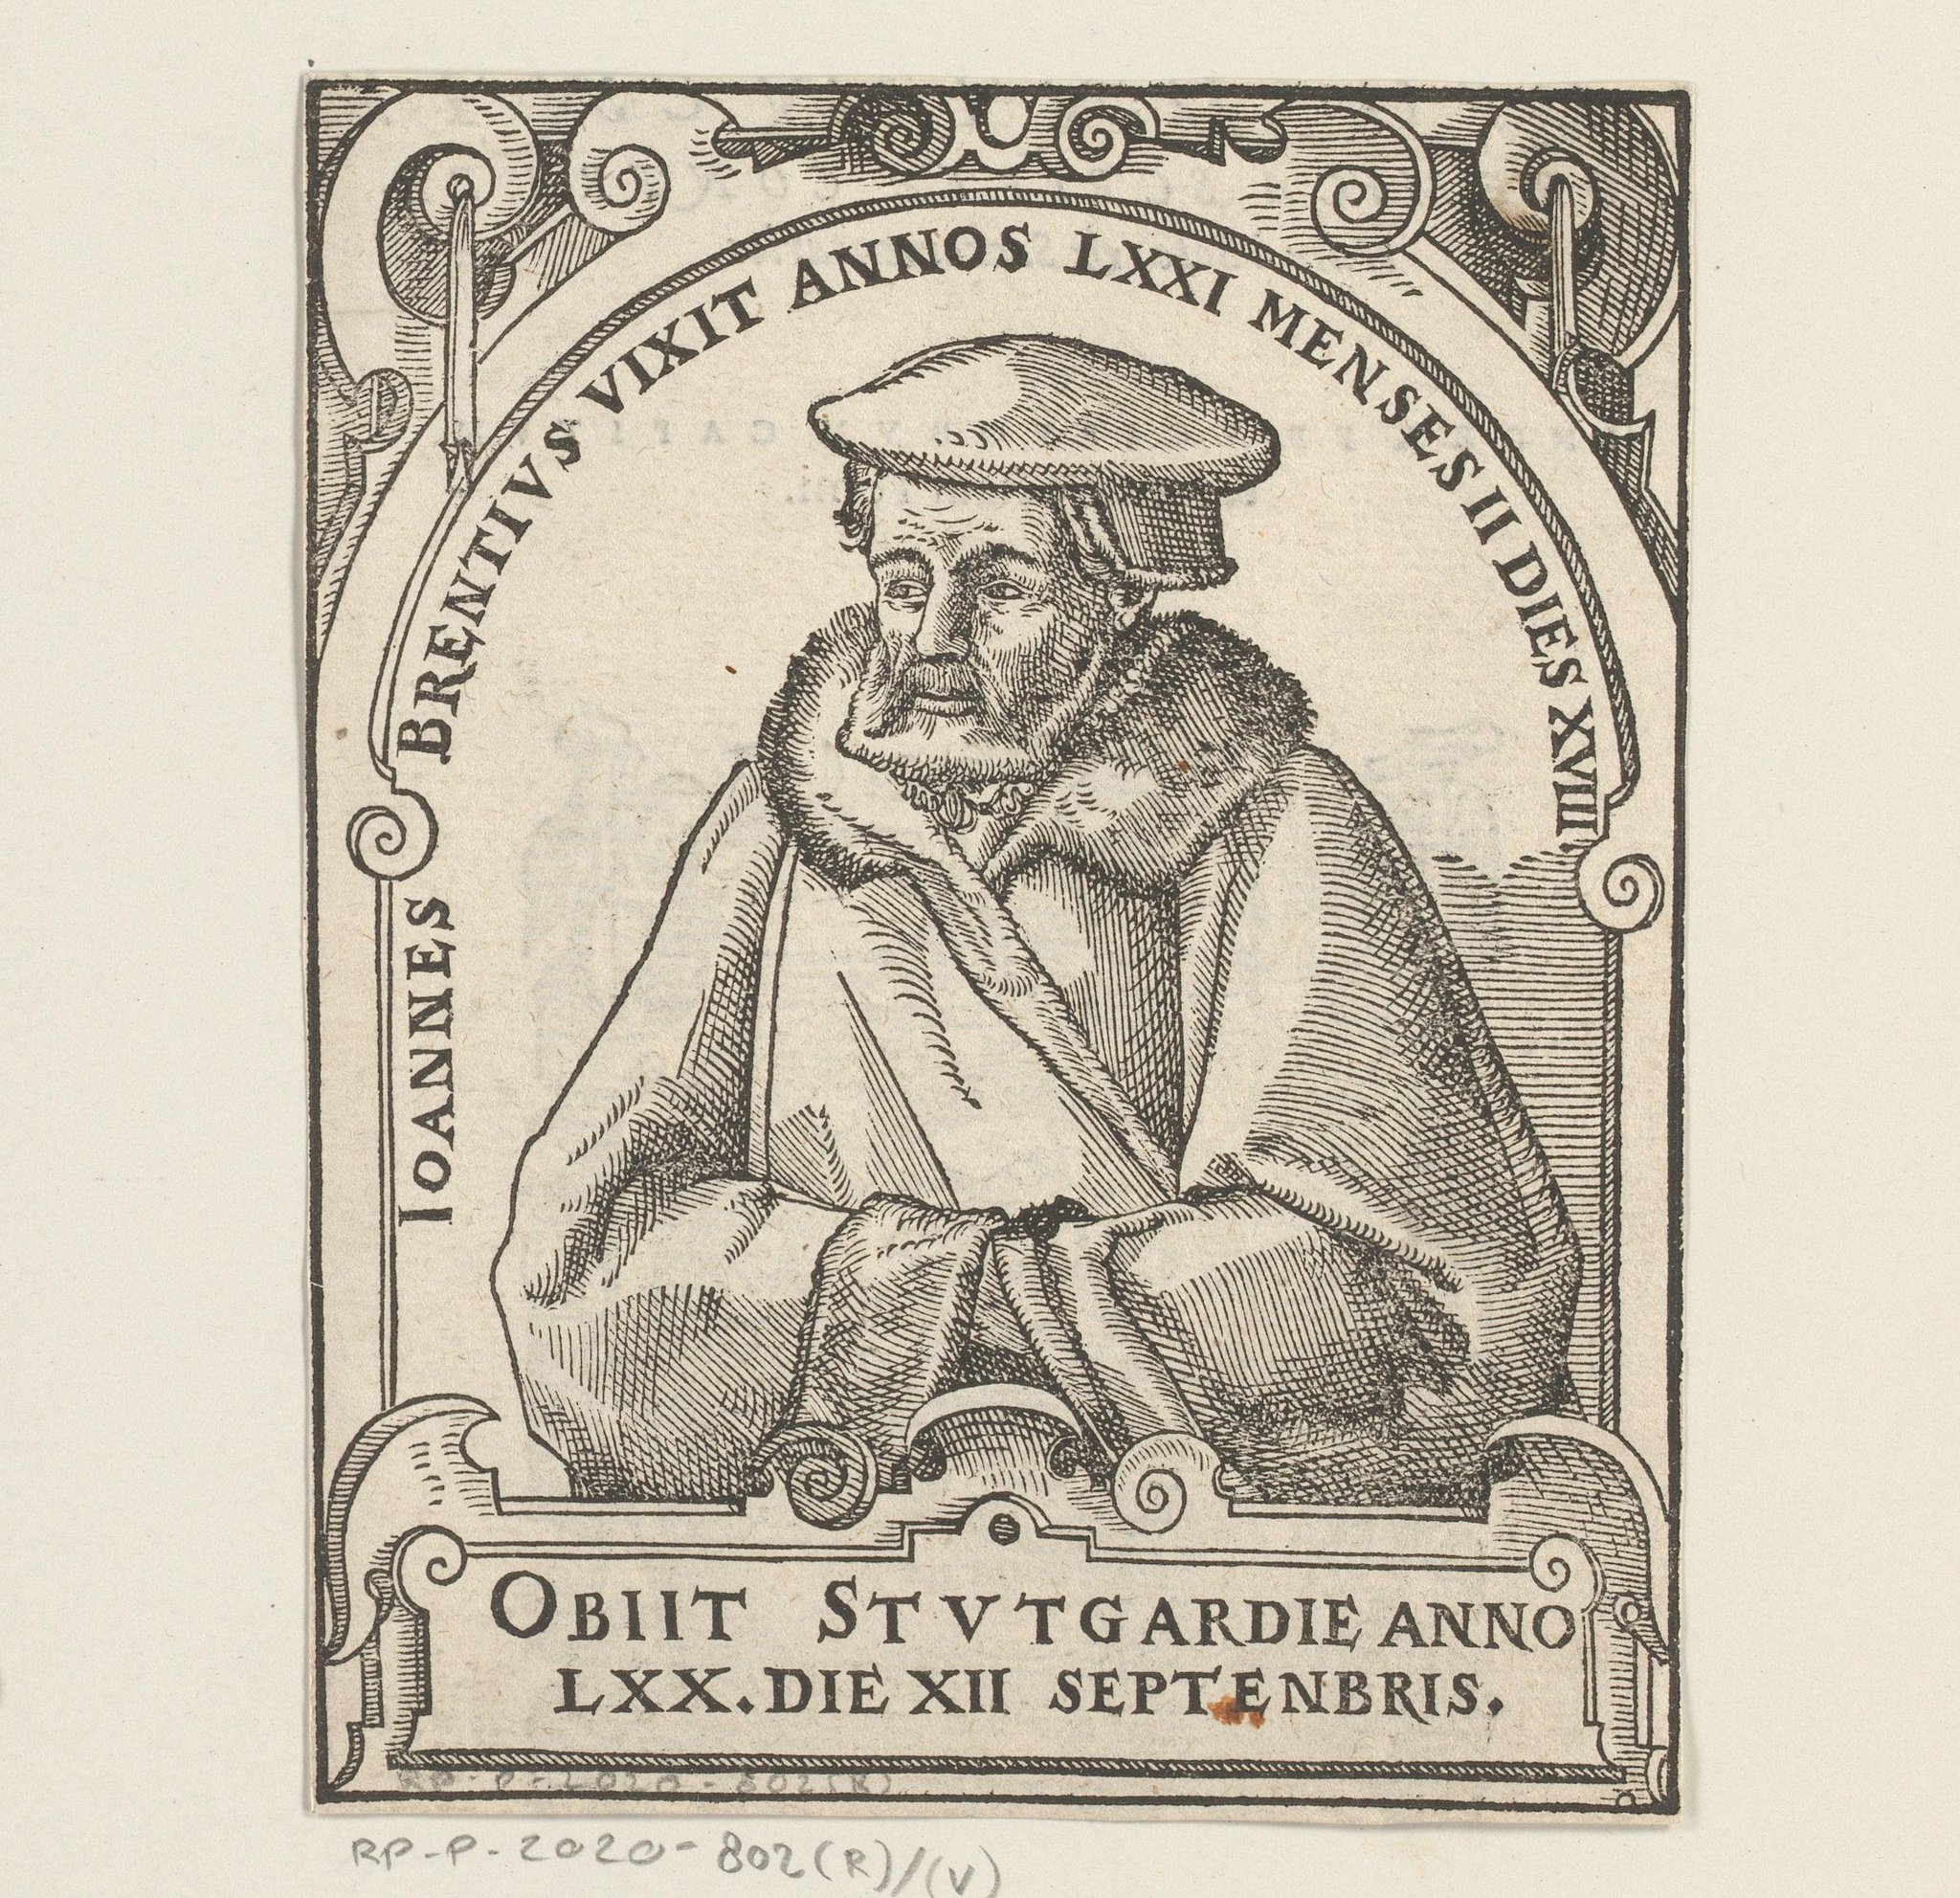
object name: print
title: Joannes Brentius vixit LXXI menses II dies XVIII (...)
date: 1590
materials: paper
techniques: woodcut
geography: tübingen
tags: theologian, historical persons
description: Prent uit: Brenz, Johannes. Operum (...) tomus octavus, in quo continentur polemica scripta contra Petrum à Soto, et sacramentarios. Tübingen: Georg Gruppenach, 1590.